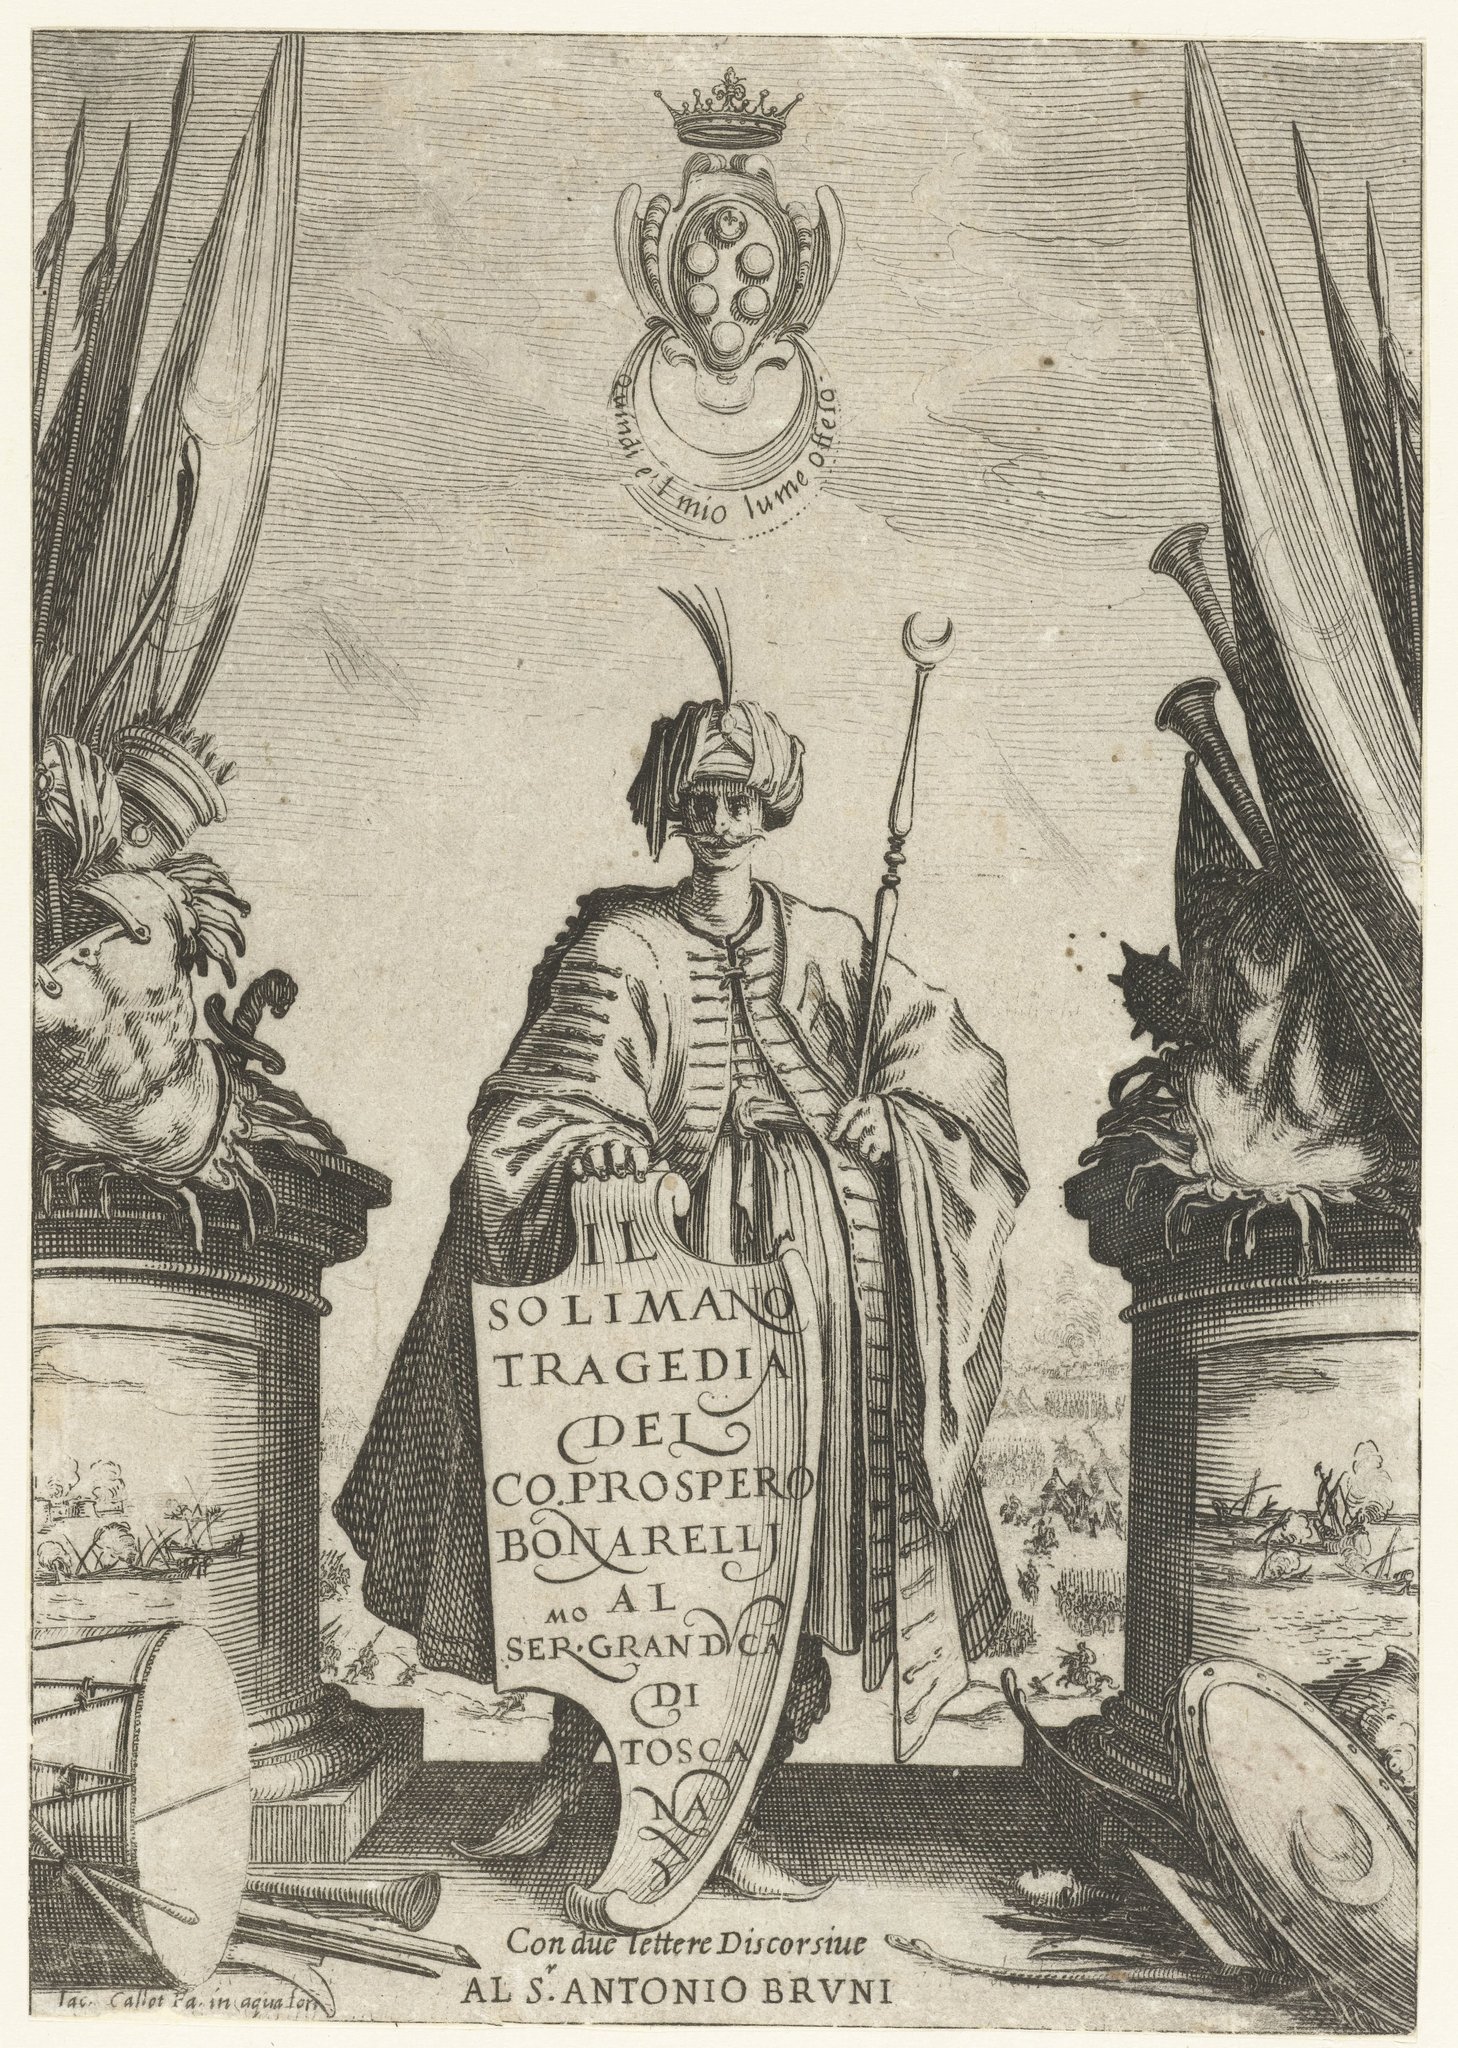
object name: titelblad, titelpagina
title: Titelblad voor de tragedie 'Il Solimano'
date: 1619-1620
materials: paper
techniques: engraving, etching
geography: florence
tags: cosimo ii de' medici, asiatic races and peoples: turks, title-page, weapons, armorial bearing, heraldry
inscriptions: collector's mark: Lugt 240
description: Sultan Suleyman staat tussen twee sokkels met wapentuig, een schild met Italiaanse tekst in de hand. Boven zijn hoofd het wapen van de Medici; op de achtergrond oorlogstaferelen.